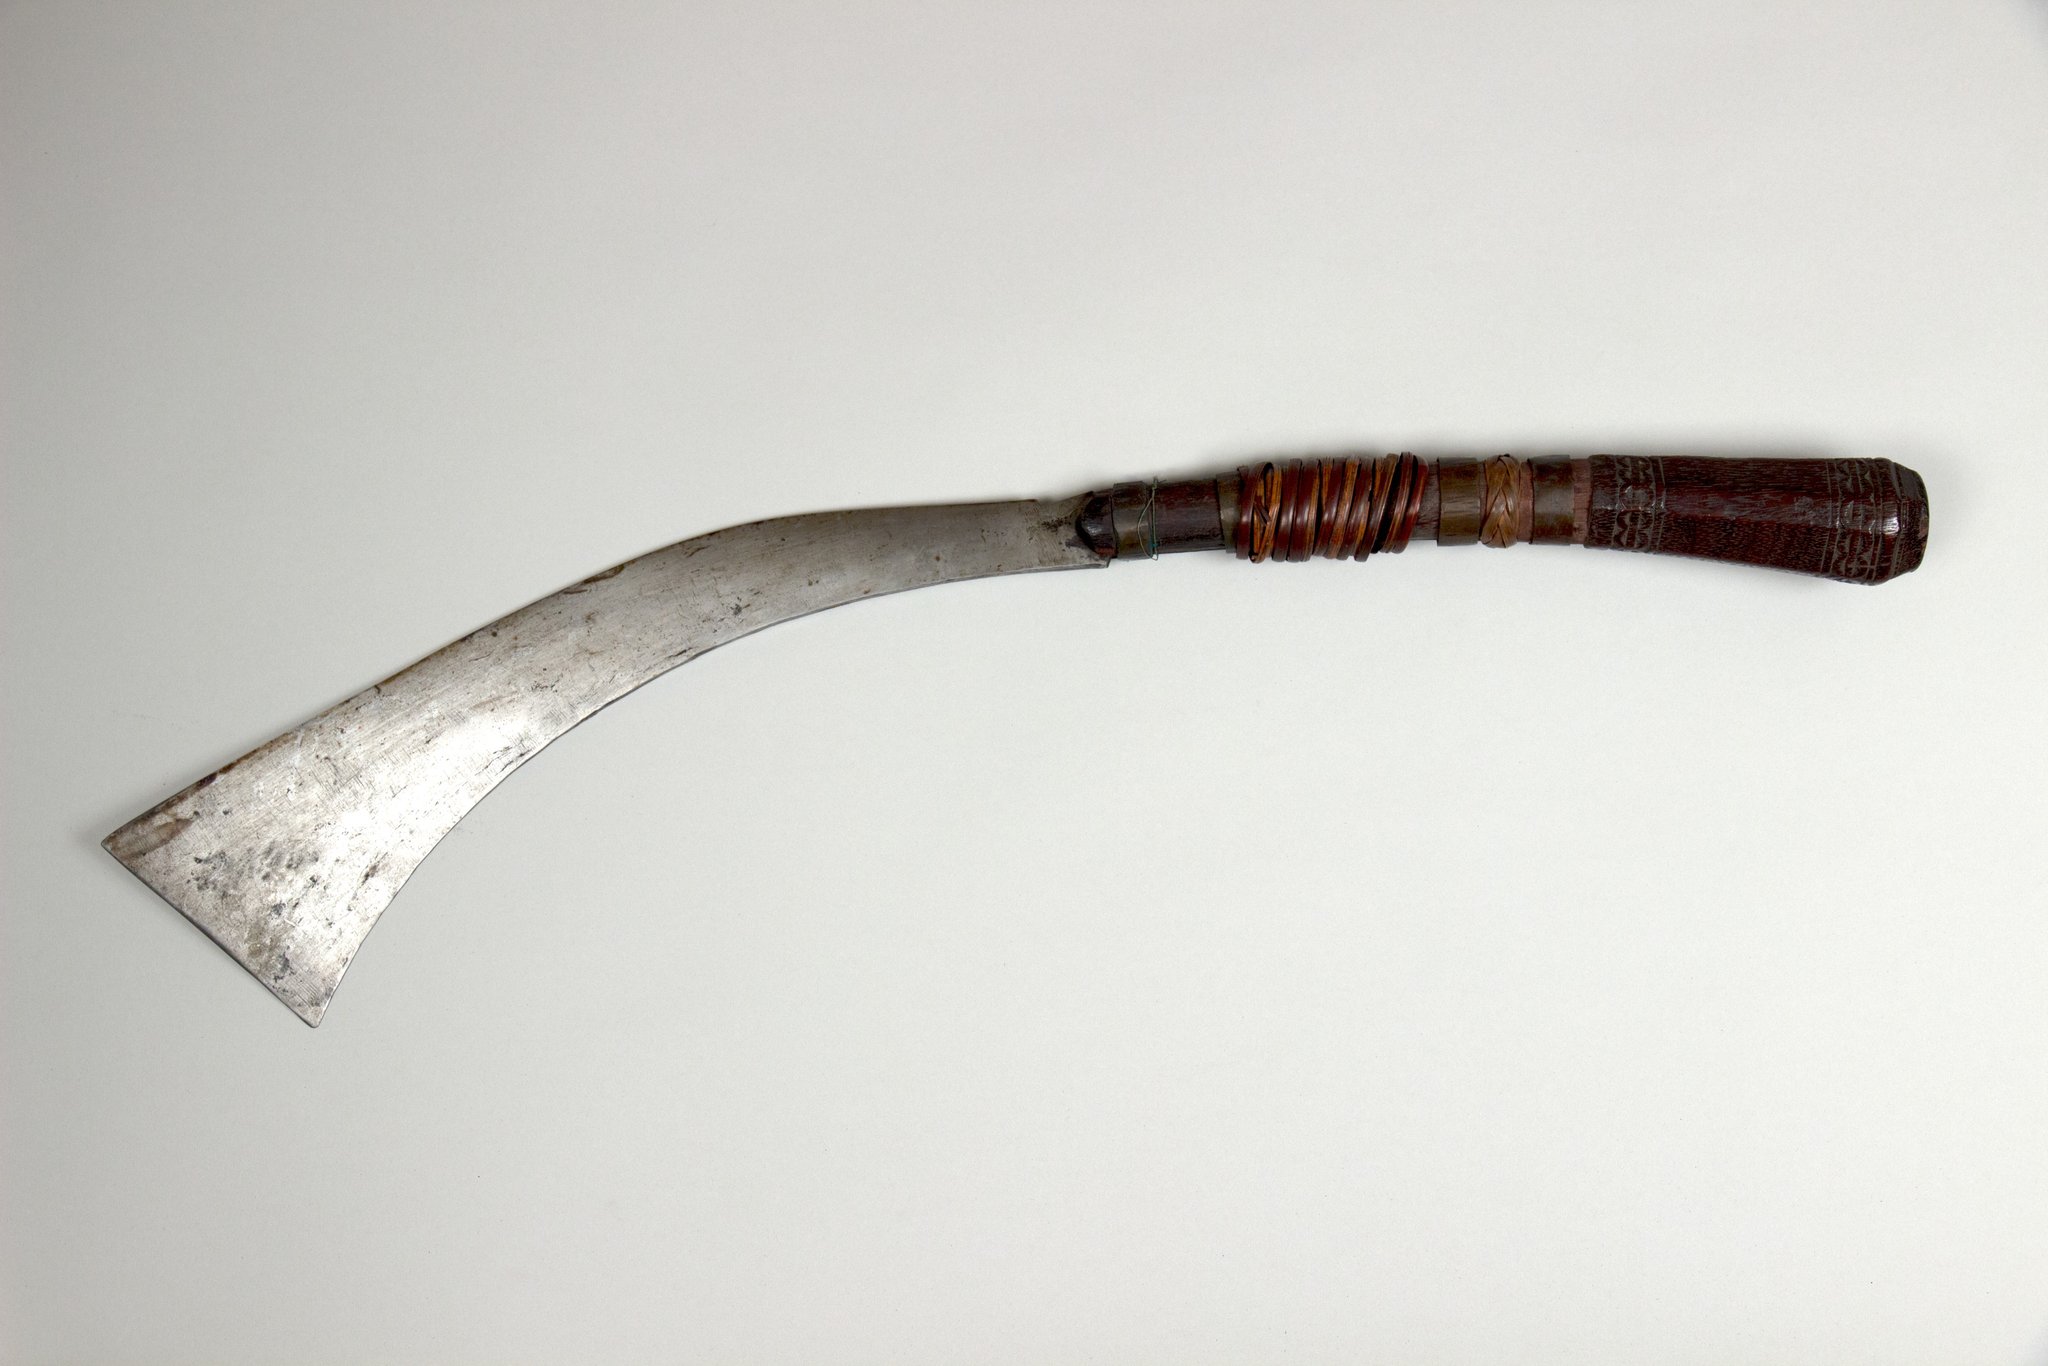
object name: sword panabas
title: Sword (Panabas)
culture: philippine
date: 1701-1900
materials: steel, wood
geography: philippines